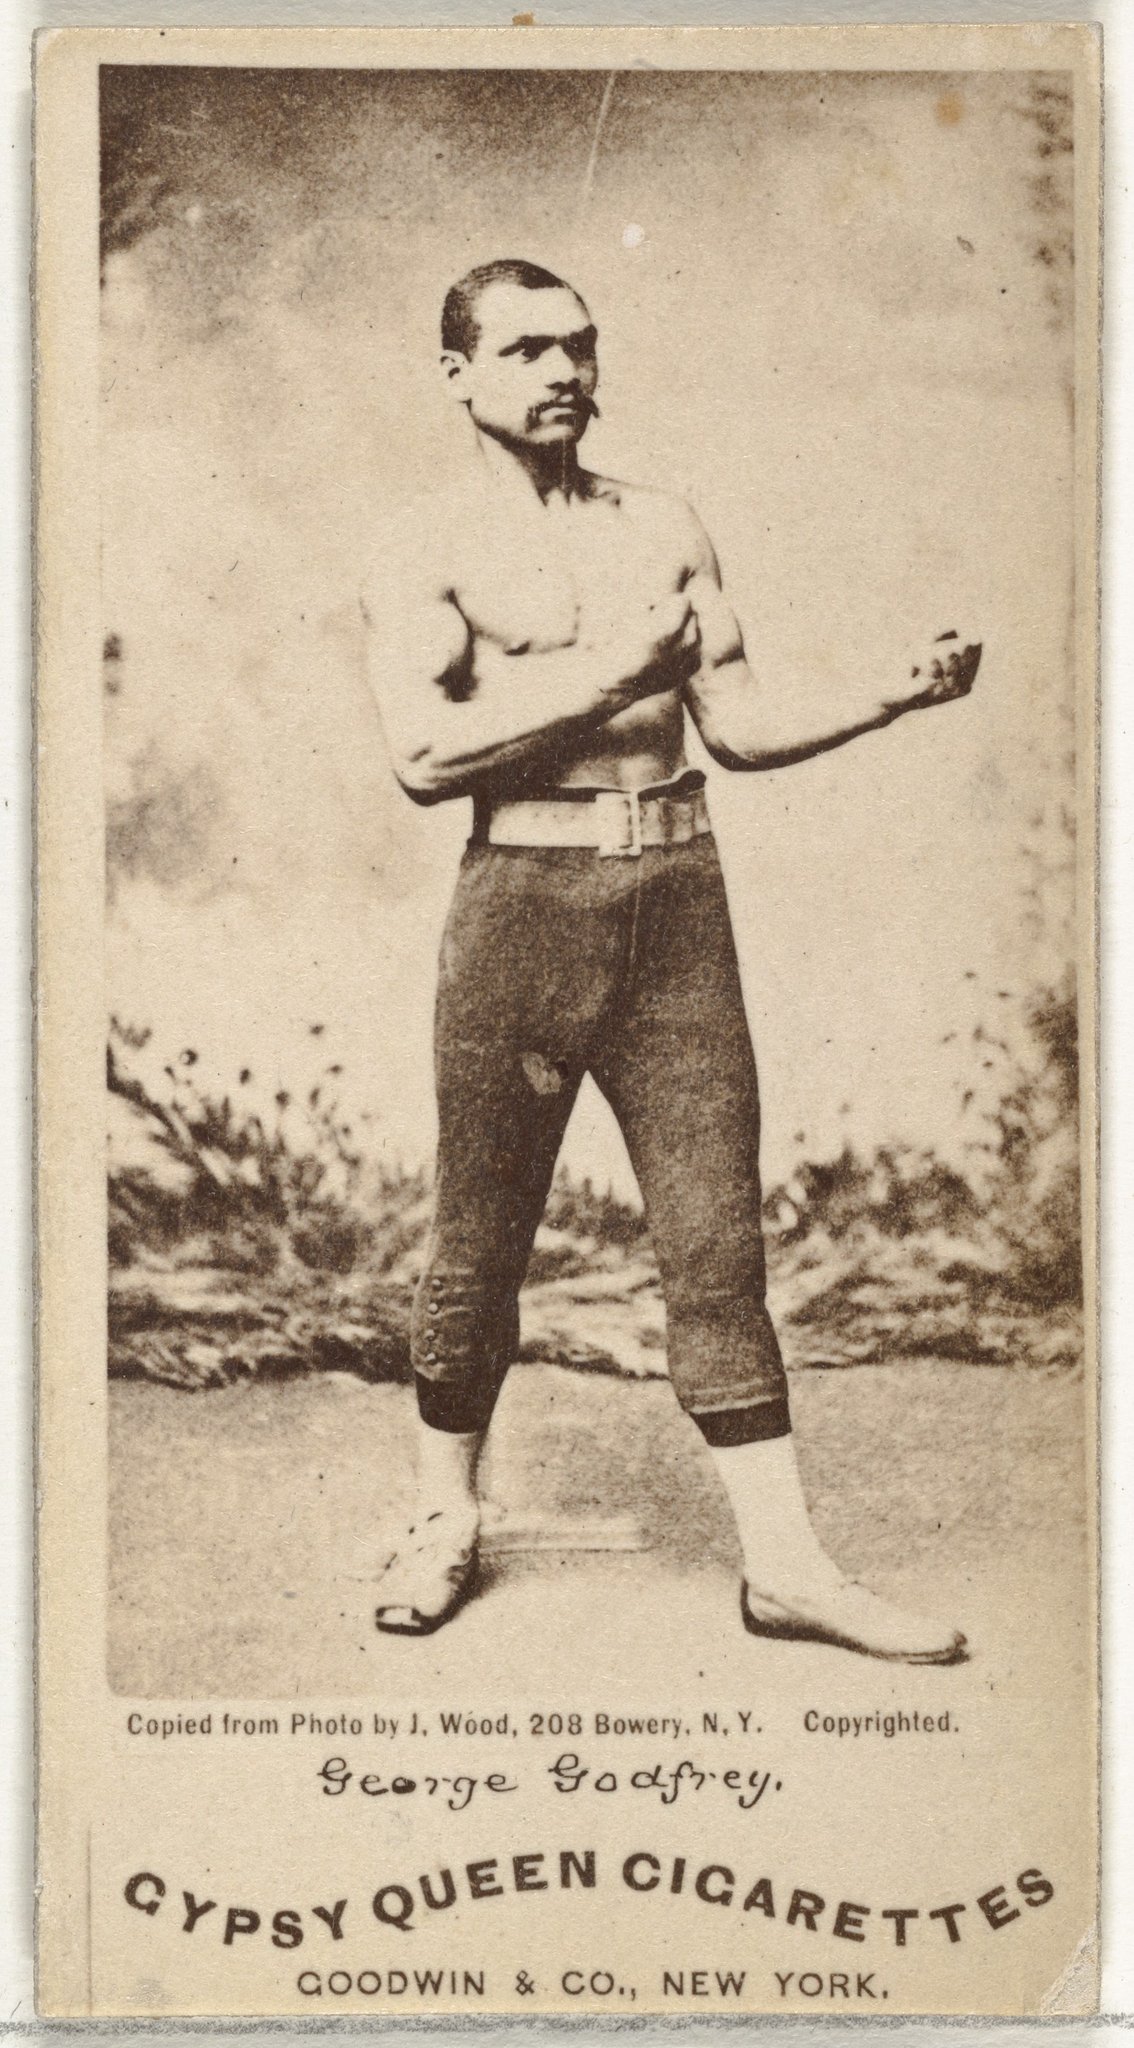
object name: photograph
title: George Godfrey, from the Celebrities and Prizefighters series (N174) for Gypsy Queen Cigarettes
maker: goodwin & company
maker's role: publisher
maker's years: 1850-1950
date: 1887-1888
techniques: albumen silver print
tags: men,portraits,boxing,athletes